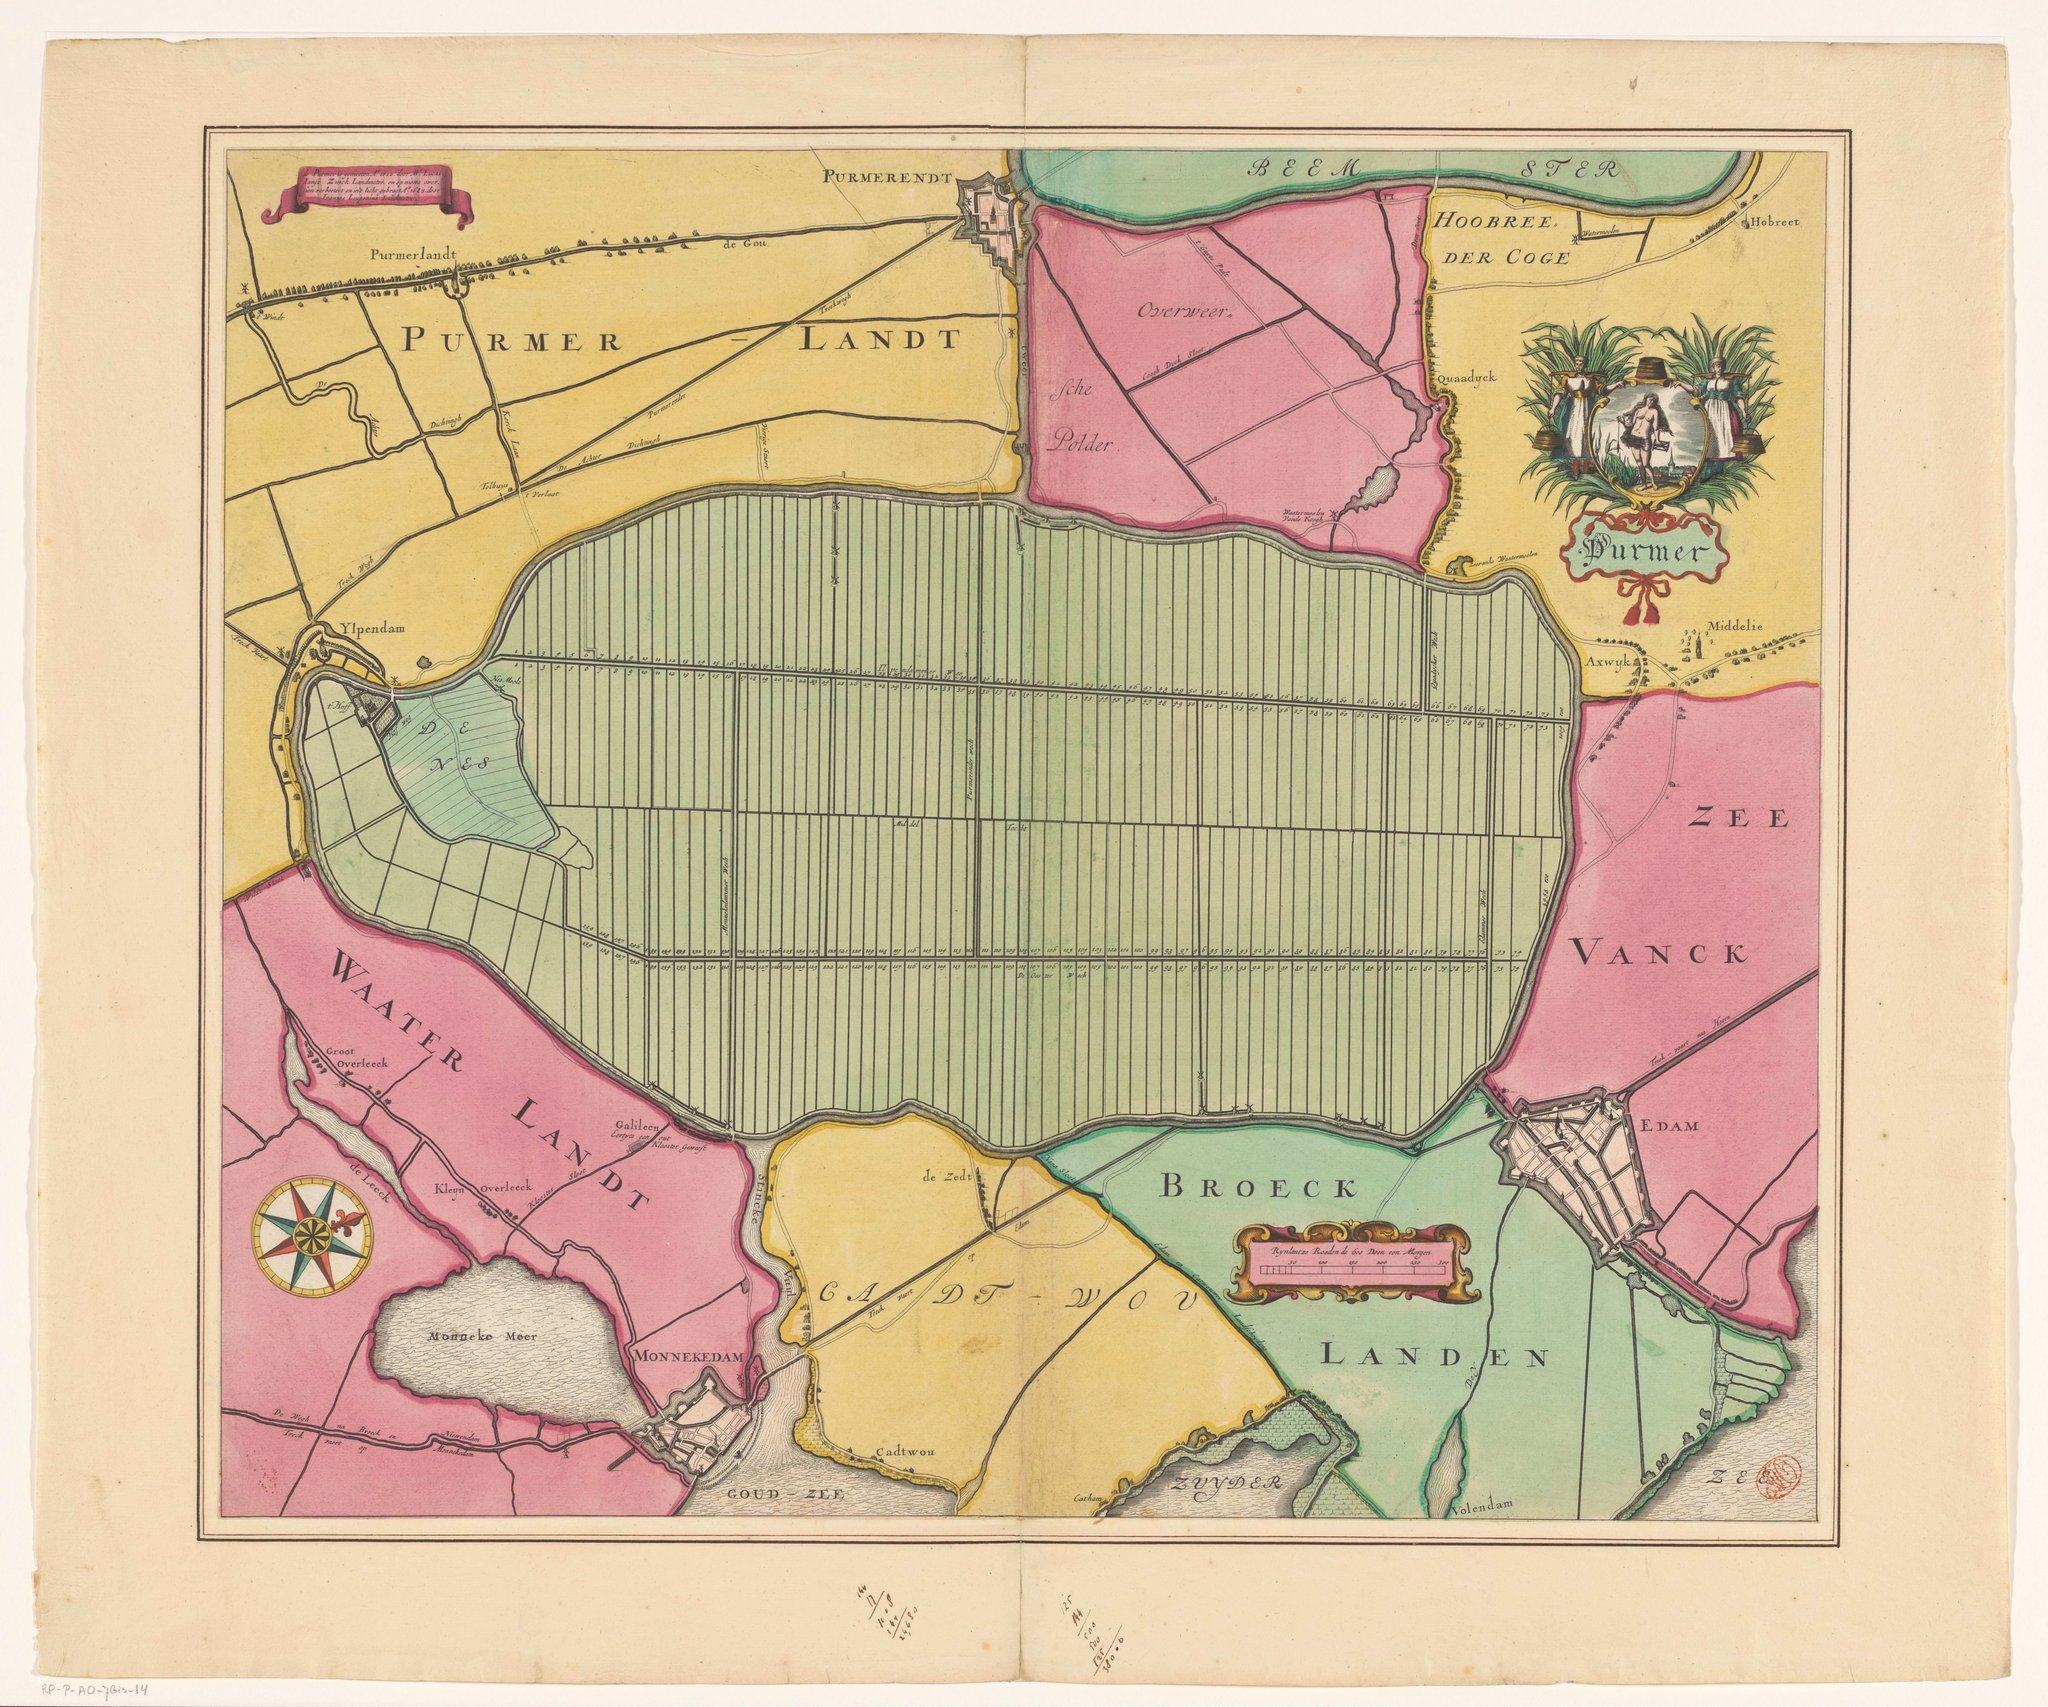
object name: print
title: Kaart van de Purmer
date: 1683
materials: paper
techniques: engraving, etching, hand coloring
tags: coat of arms (as symbol of the state, etc.), maps of separate countries or regions, polder, reclaimed land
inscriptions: collector's mark: Lugt 195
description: Rechtsboven het wapen van de Purmer, rechtsonder een schaalstok: Rynlantze roeden de 600 doen een morgen.